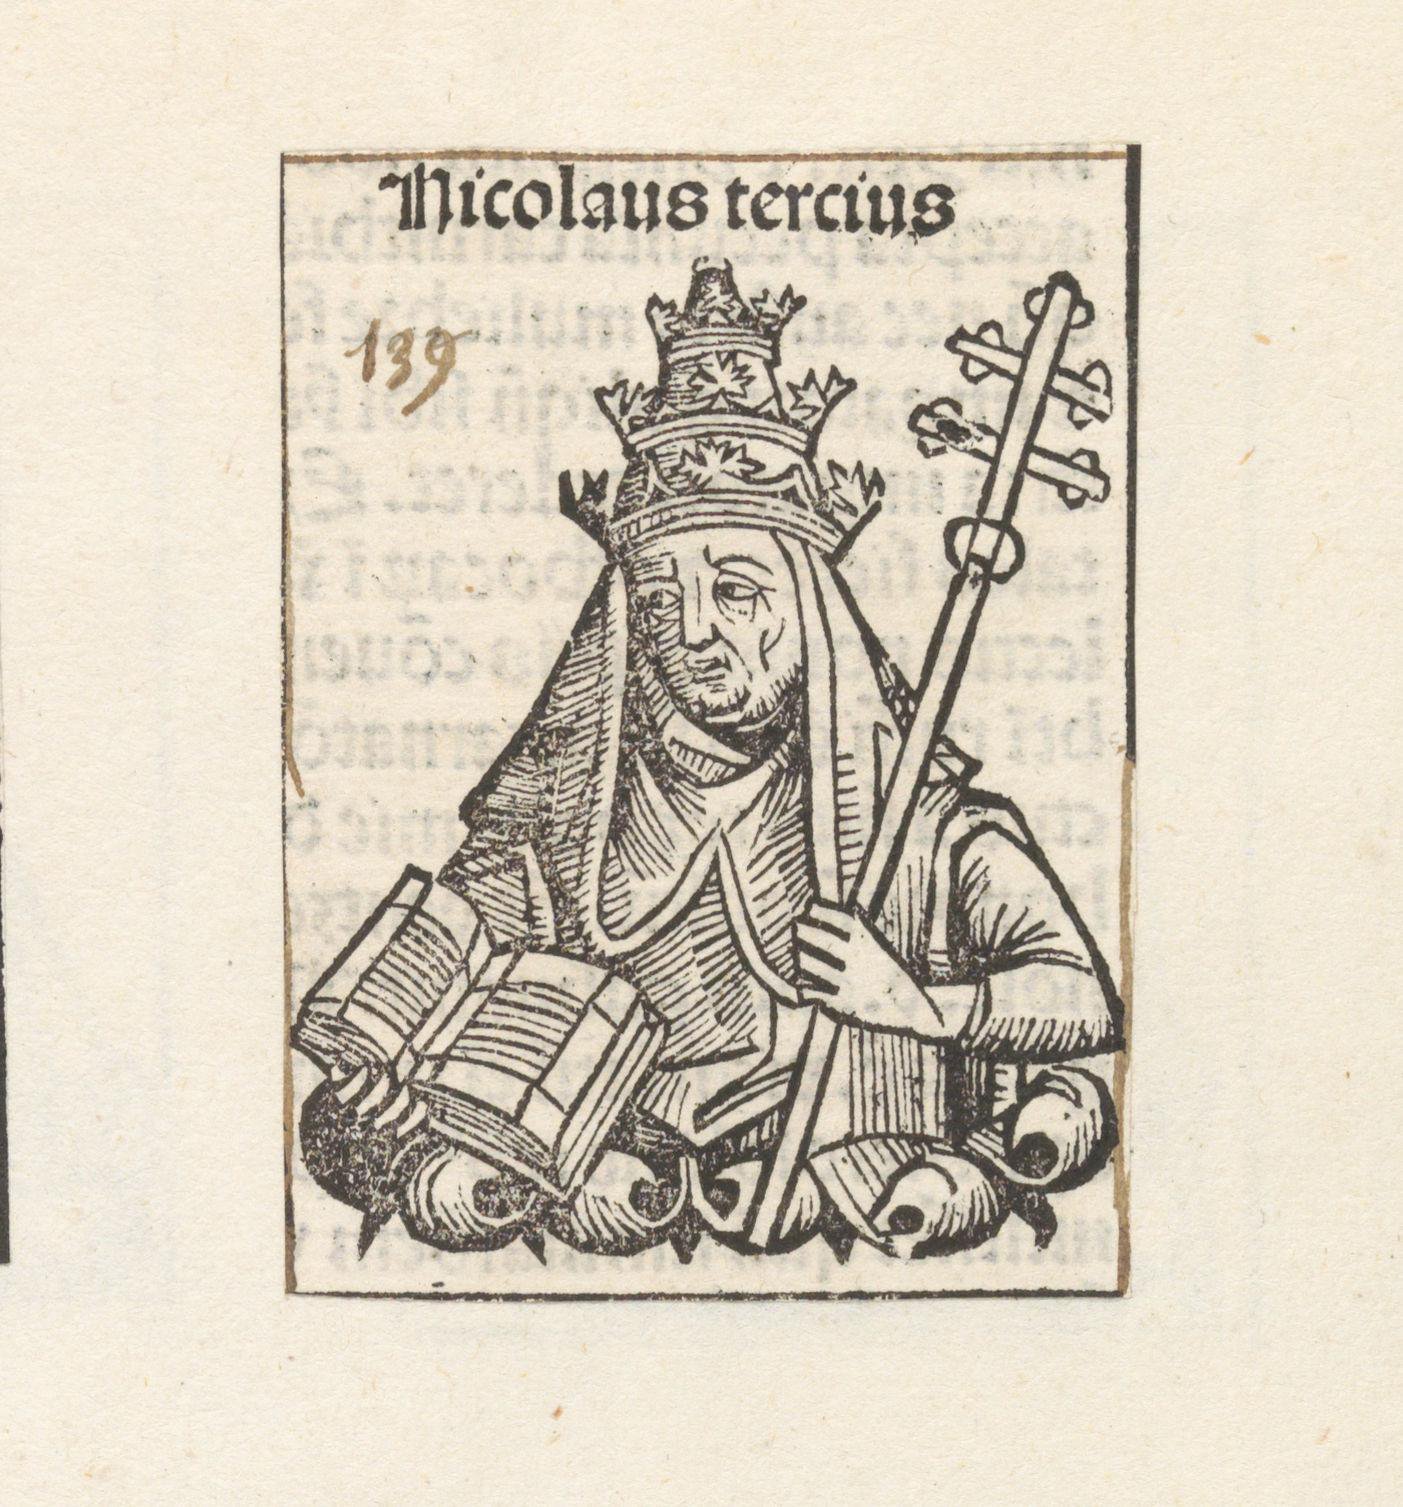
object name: print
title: Liber Chronicarum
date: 1493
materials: paper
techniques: letterpress printing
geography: nuremberg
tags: rome, pope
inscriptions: inscription: ‘139’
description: Een bloemkelk met een paus. Hij draagt een tiara en heeft een opengeslagen bijbel en een staf met dubbel kruis in zijn handen. De voorstelling is onderdeel van de opeenvolging pausen in de Liber Chronicarum. De tekst identificeert de man als Nicolaas III. De prent maakt deel uit van een album.